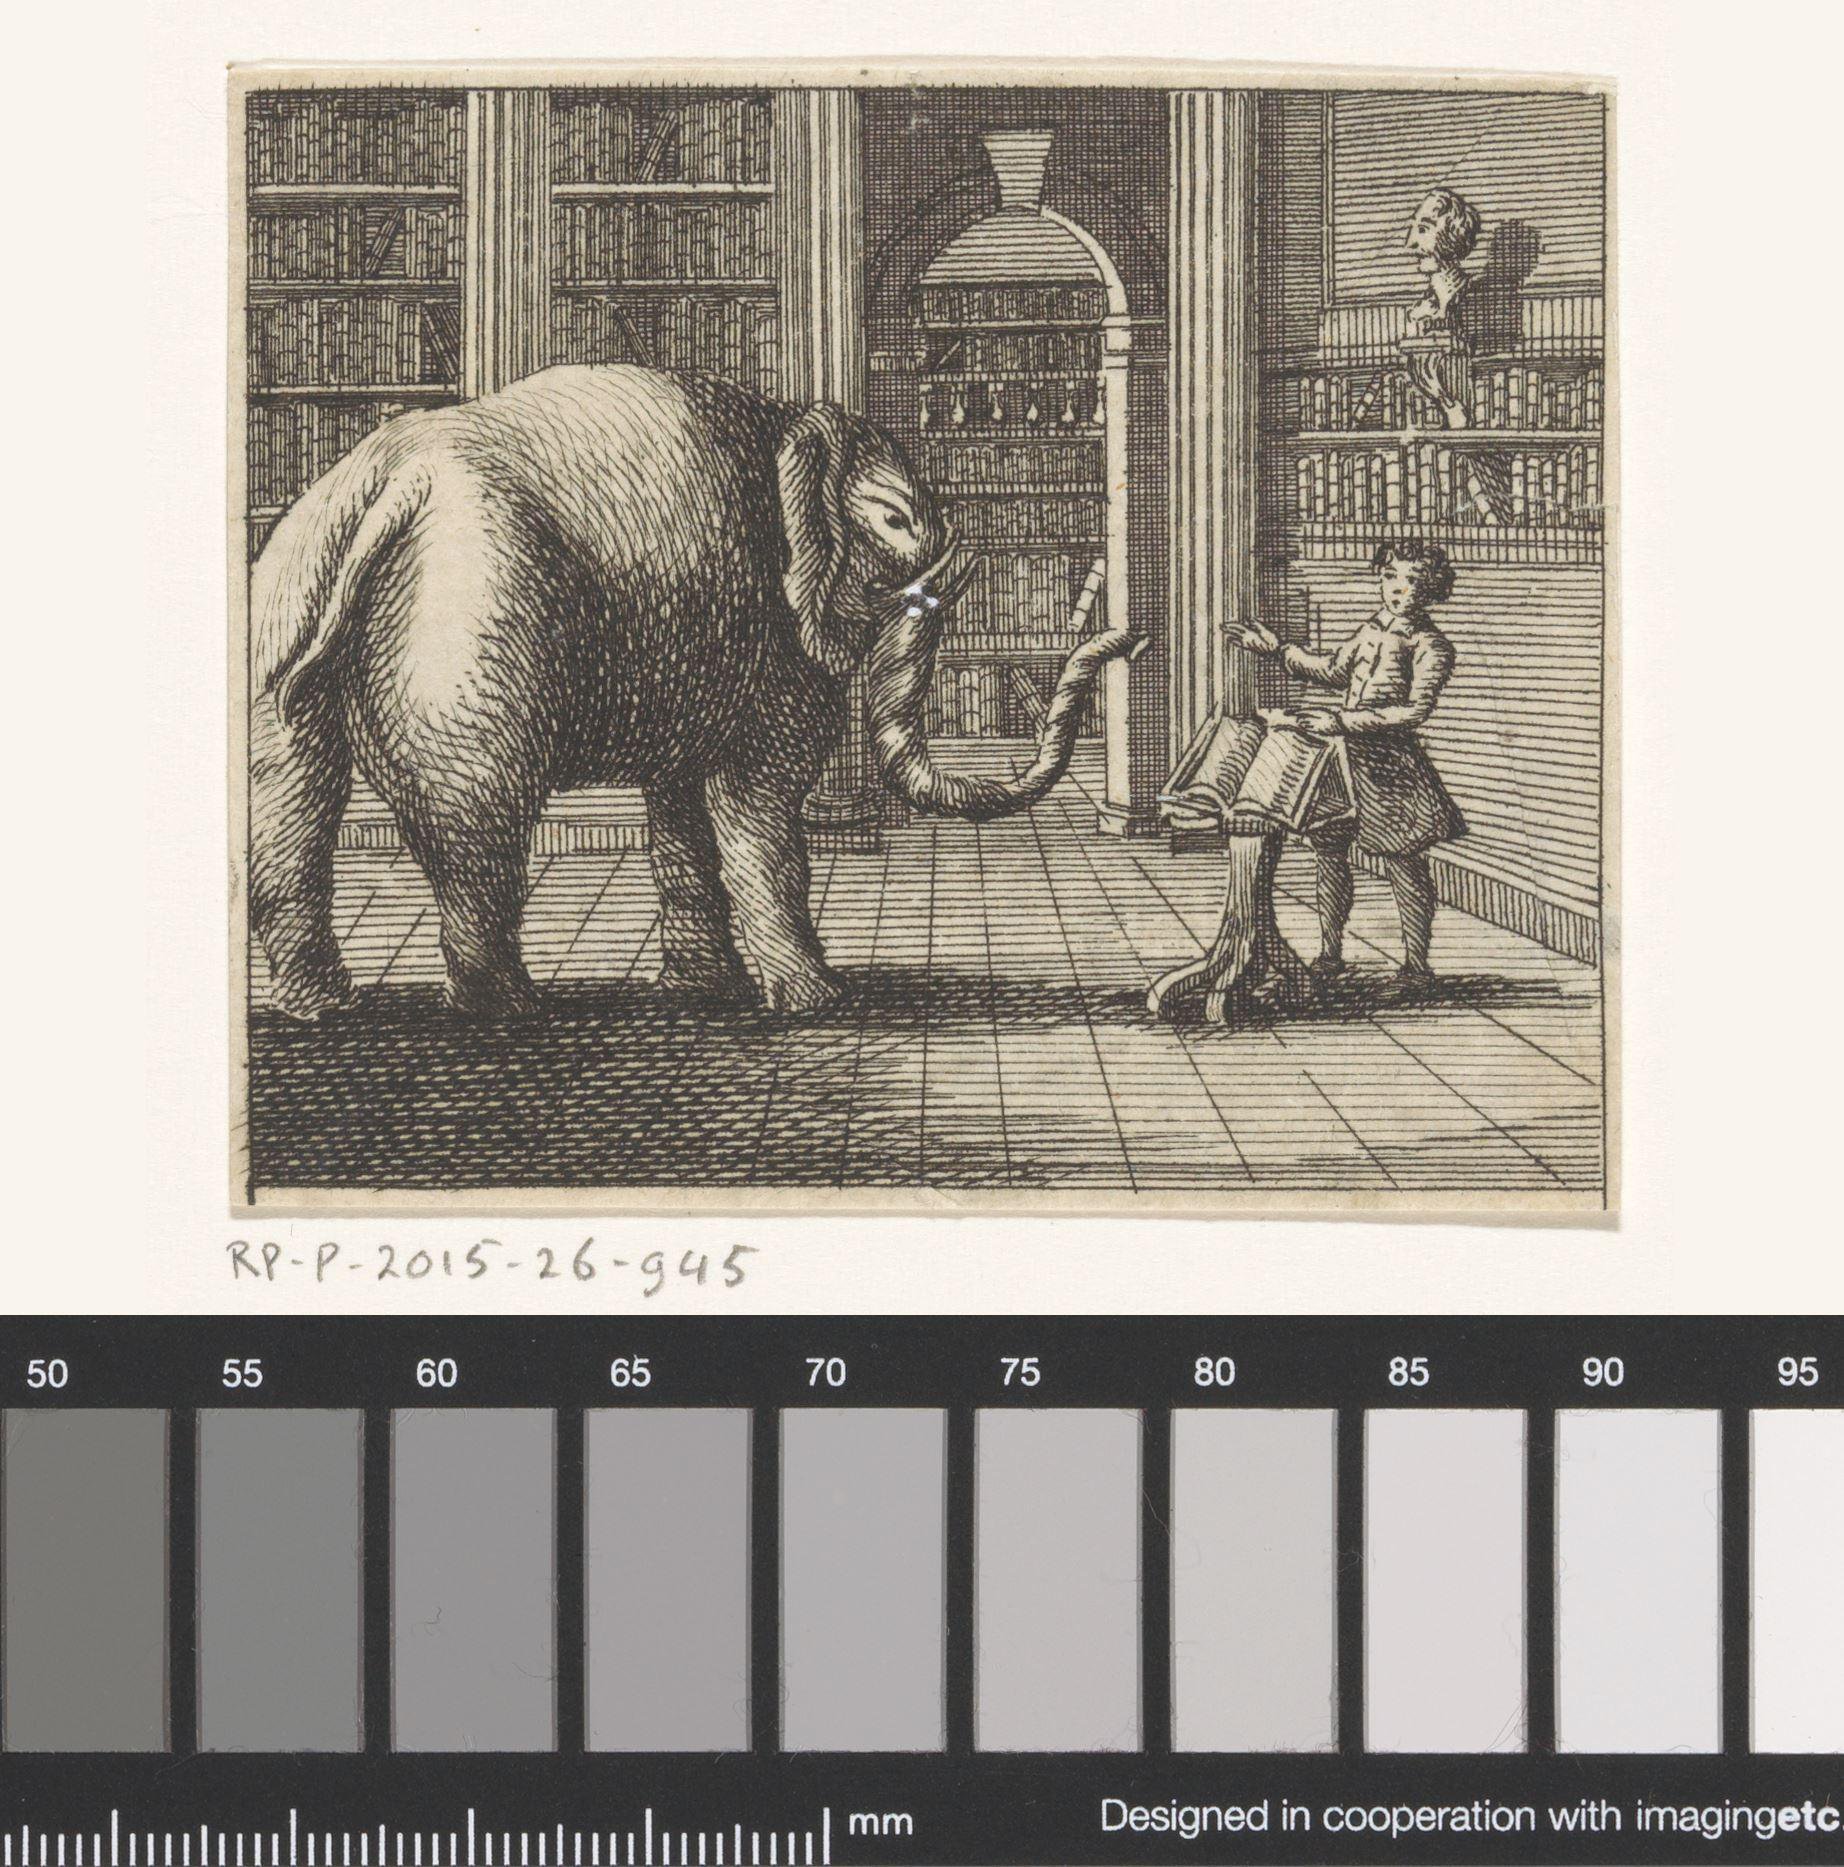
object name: print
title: Olifant en de boekverkoper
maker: Anonymous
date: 1739-1799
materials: paper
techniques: etching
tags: bookshelves, lectern ~ reading, trunked animals: elephant, book-shop, bookseller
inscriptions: collector's mark: Lugt 2228, collector's mark: Lugt 4779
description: De prent illustreert een fabel getiteld 'The Elephant and the Bookseller' uit de fabelen van John Gay, voor het eerst uitgegeven in 1727 met illustraties naar William Kent. Deze prent is waarschijnlijk gebruikt als boekillustratie in een latere editie.